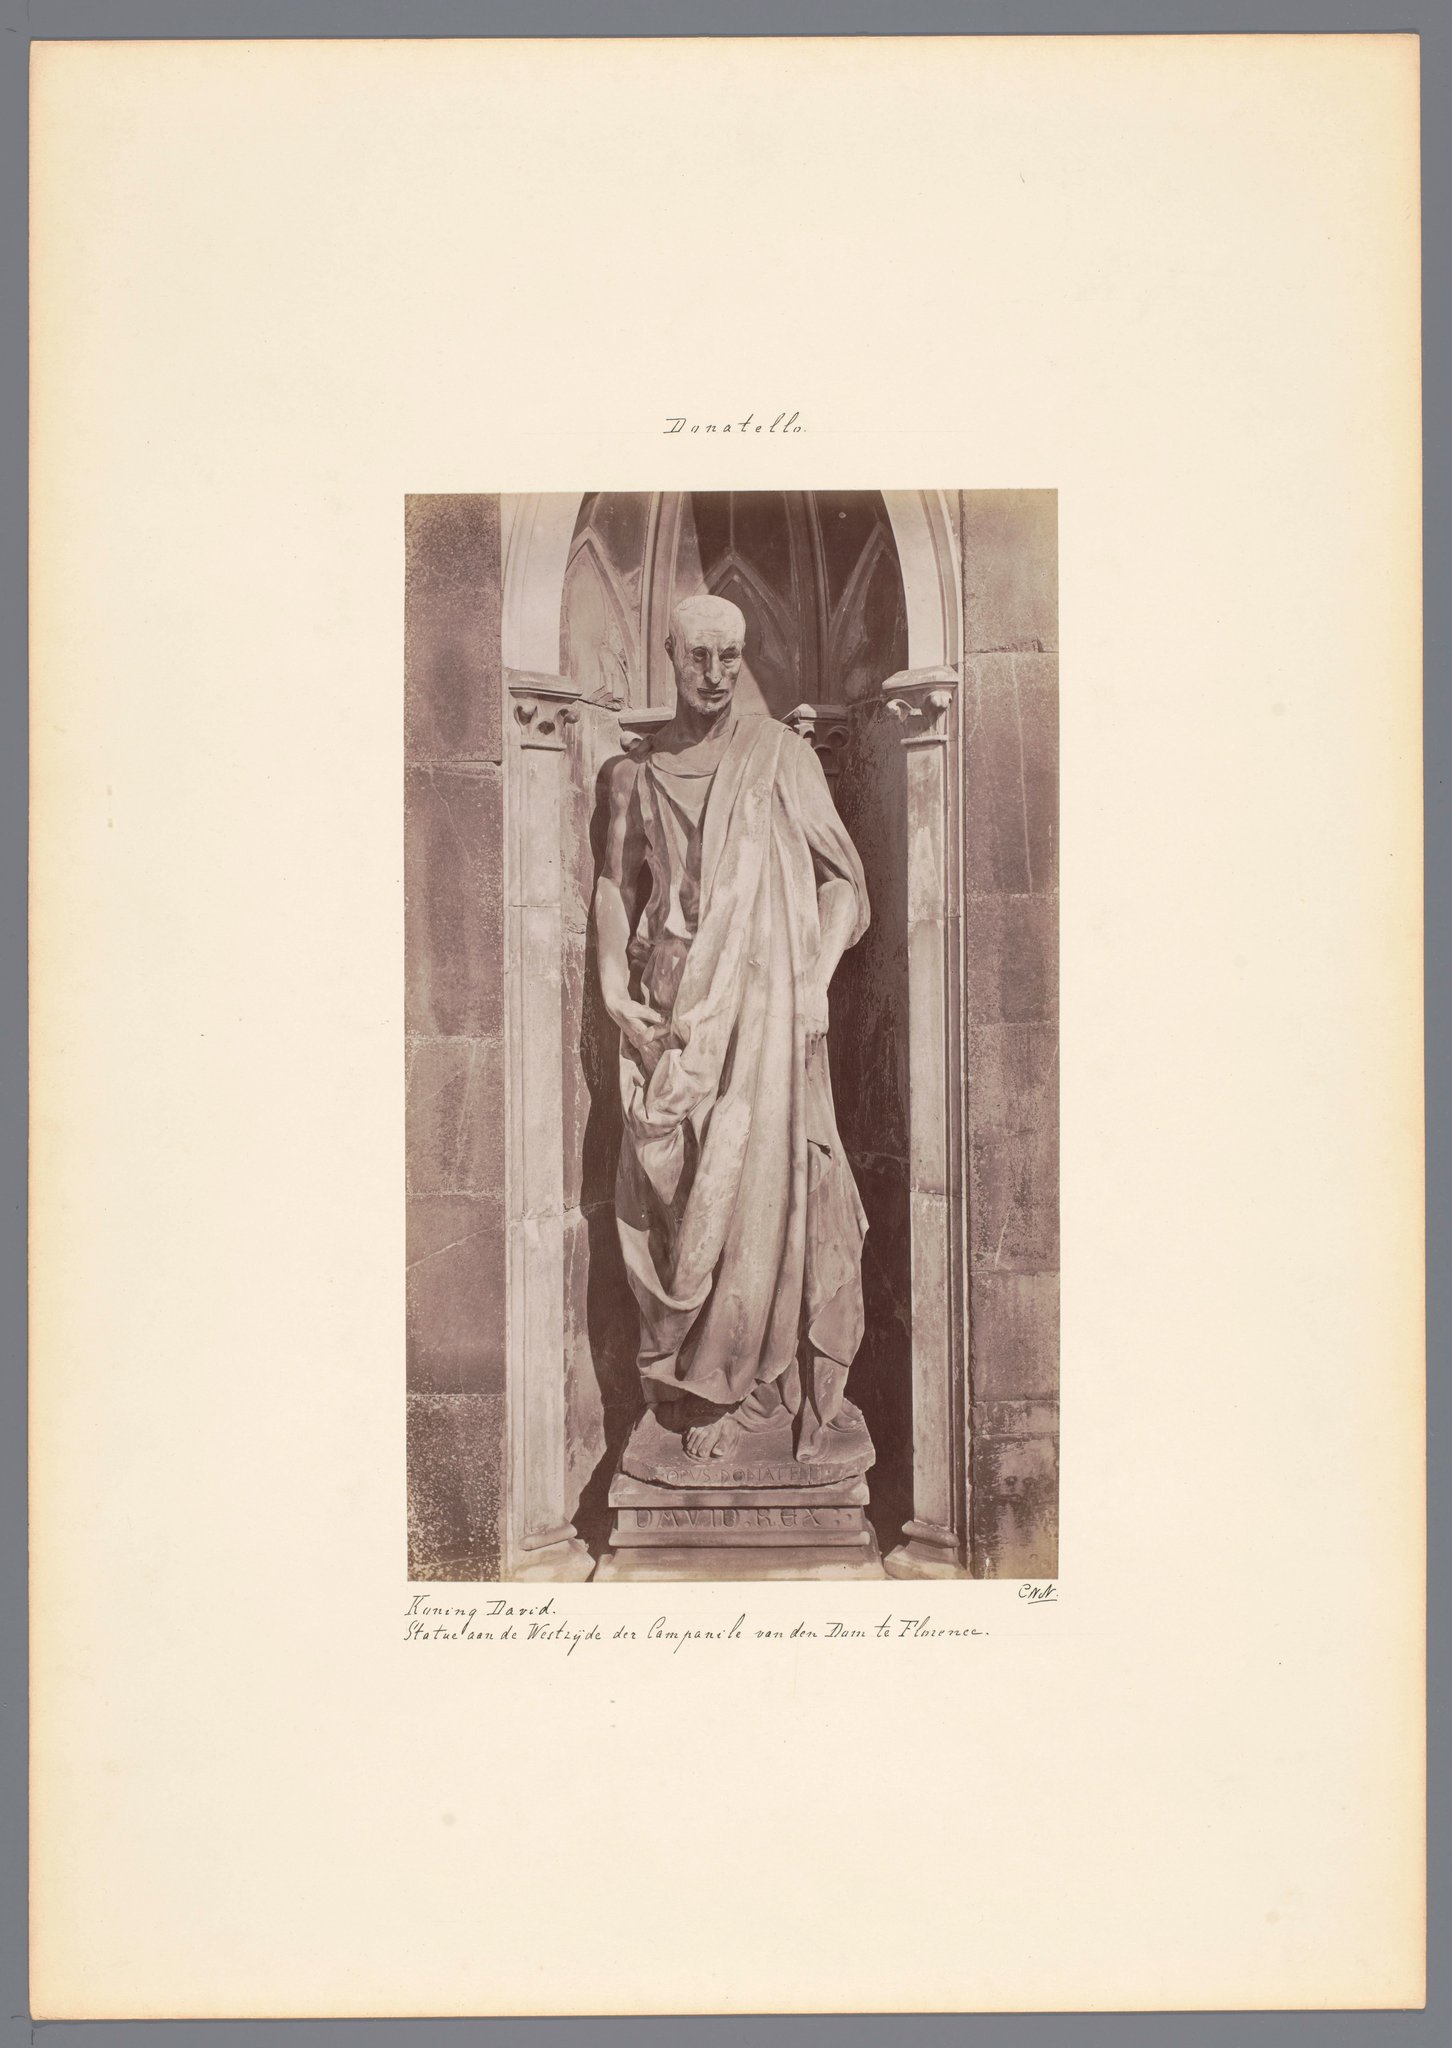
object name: photograph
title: Donatello. Koning David. Statue aan de Westzijde der Campanile van den Dom te Florence.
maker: Anonymous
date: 1875-1900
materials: cardboard, photographic support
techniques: albumen print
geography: florence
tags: story of david, monument, statue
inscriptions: collector's mark: ‘INSTITUUT VOOR KUNST-NIJVERHEIDSONDERWIJS GABRIËL METSUSTRAAT No. 16 AMSTERDAM’, collector's mark: ‘KUNSTNIJVERHEIDSCHOOL QUELLINUS AMSTERDAM FRANS HALSSTRAAT 14.’, inscription: ‘CWN.’